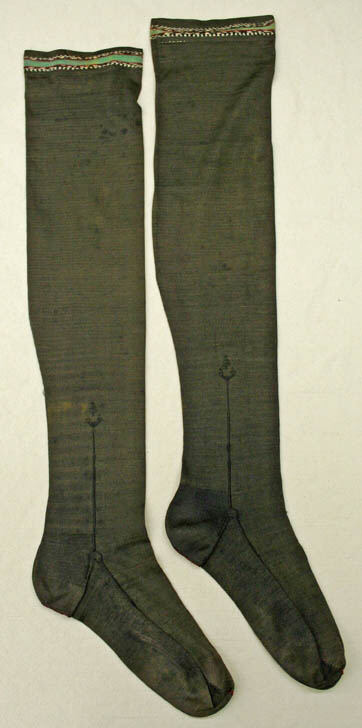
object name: stocking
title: Stockings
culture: american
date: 1859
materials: silk